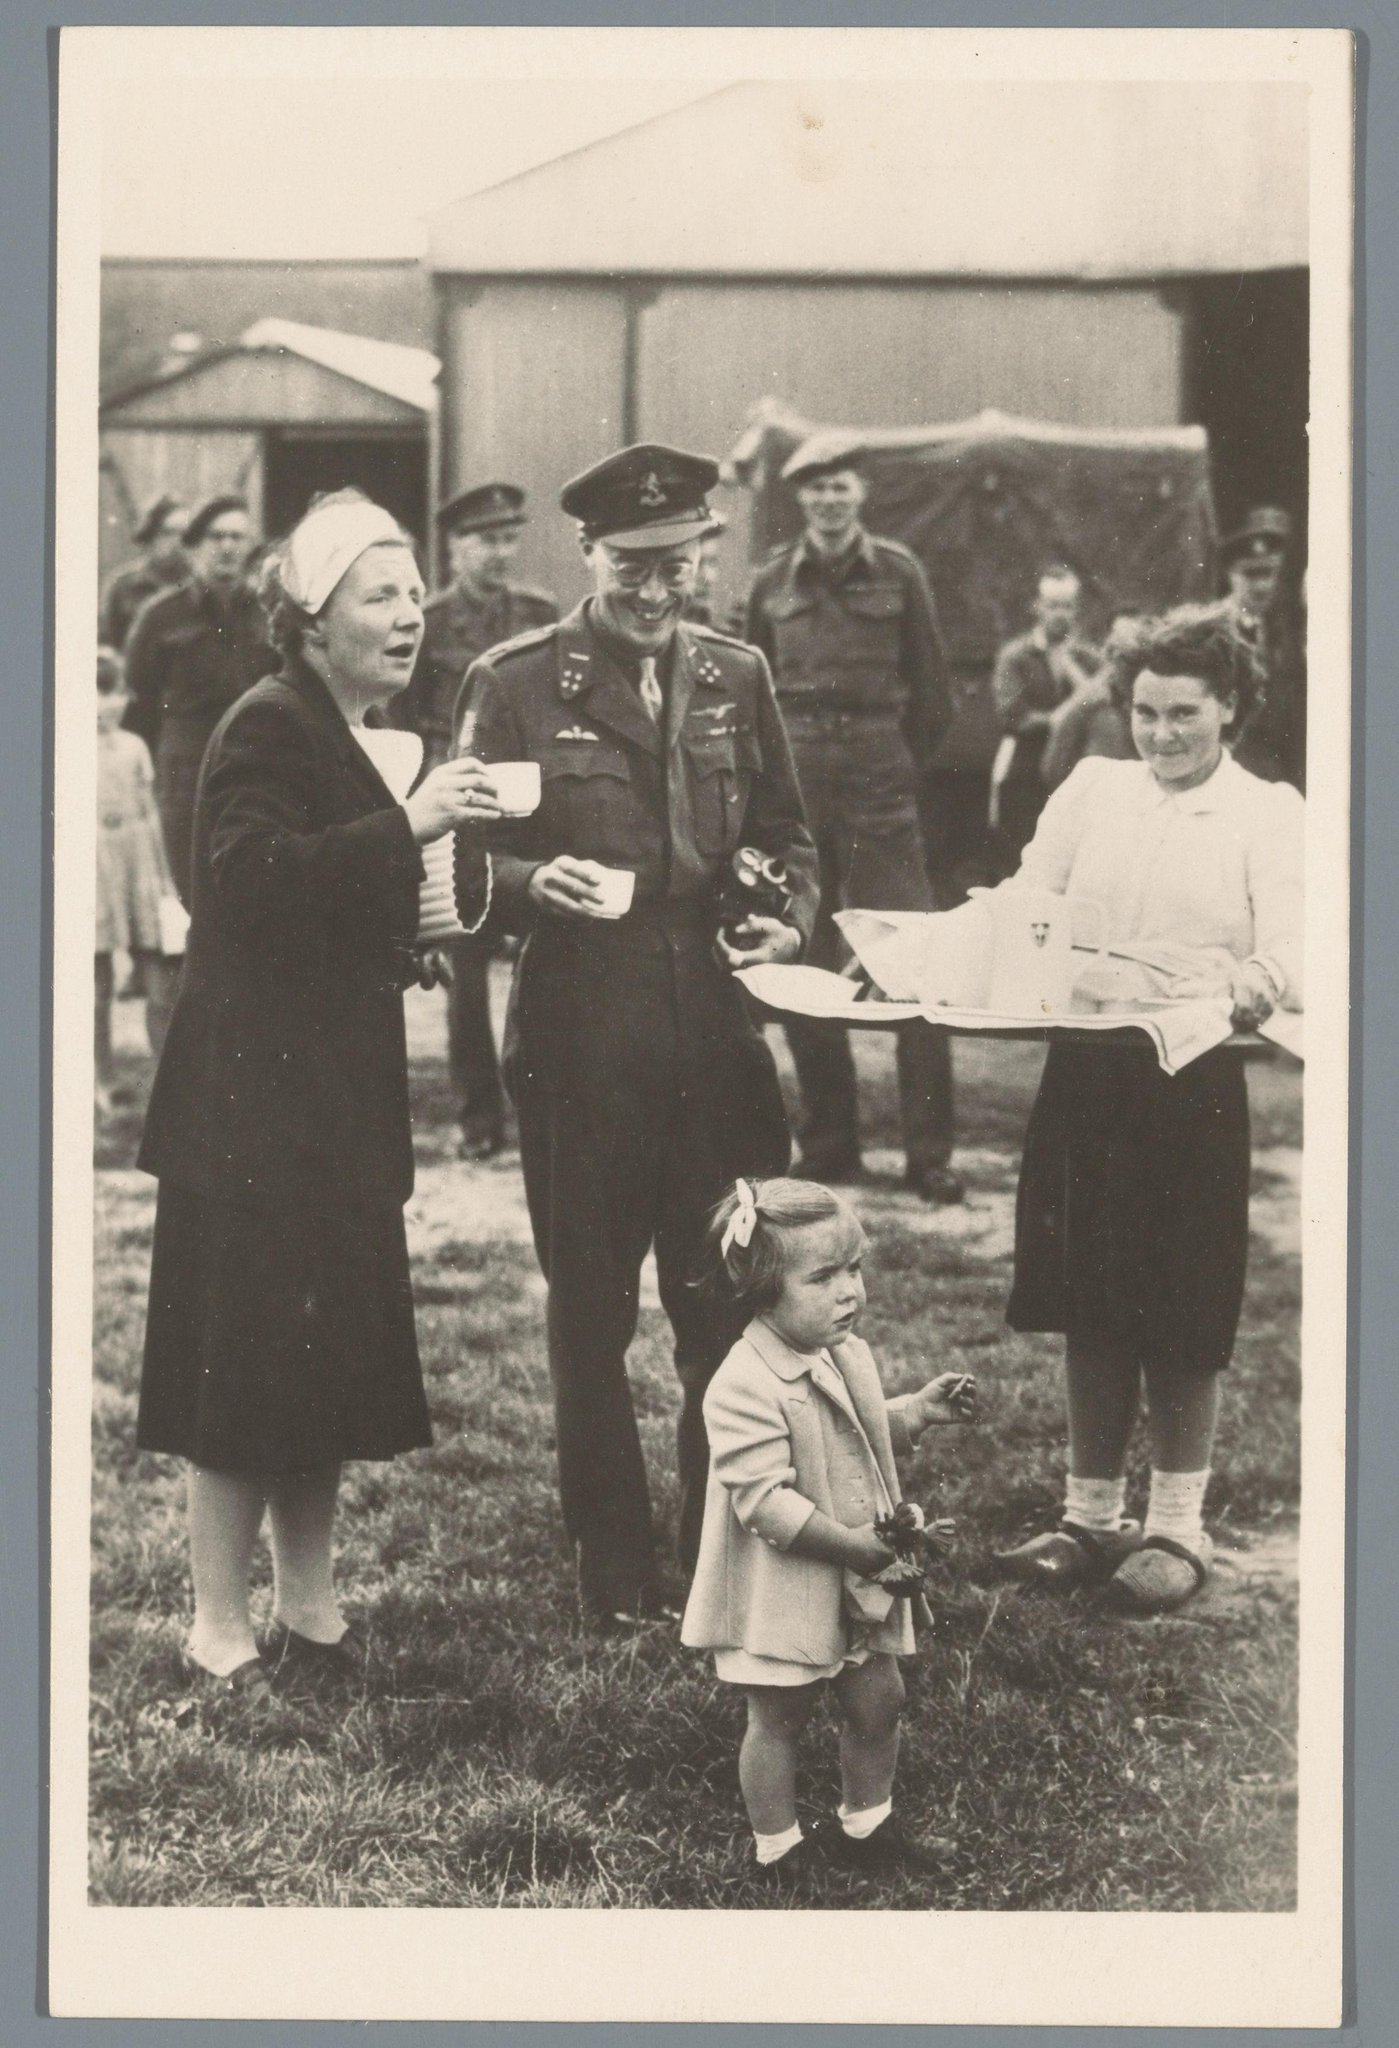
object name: photograph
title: Aankomst prinselijk gezin op Vliegveld Teuge - Augustus 1945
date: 1945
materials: photographic support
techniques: gelatin silver print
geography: teuge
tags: utrecht, bernhard (prins der nederlanden), the hague, juliana of the netherlands, family of the sovereign